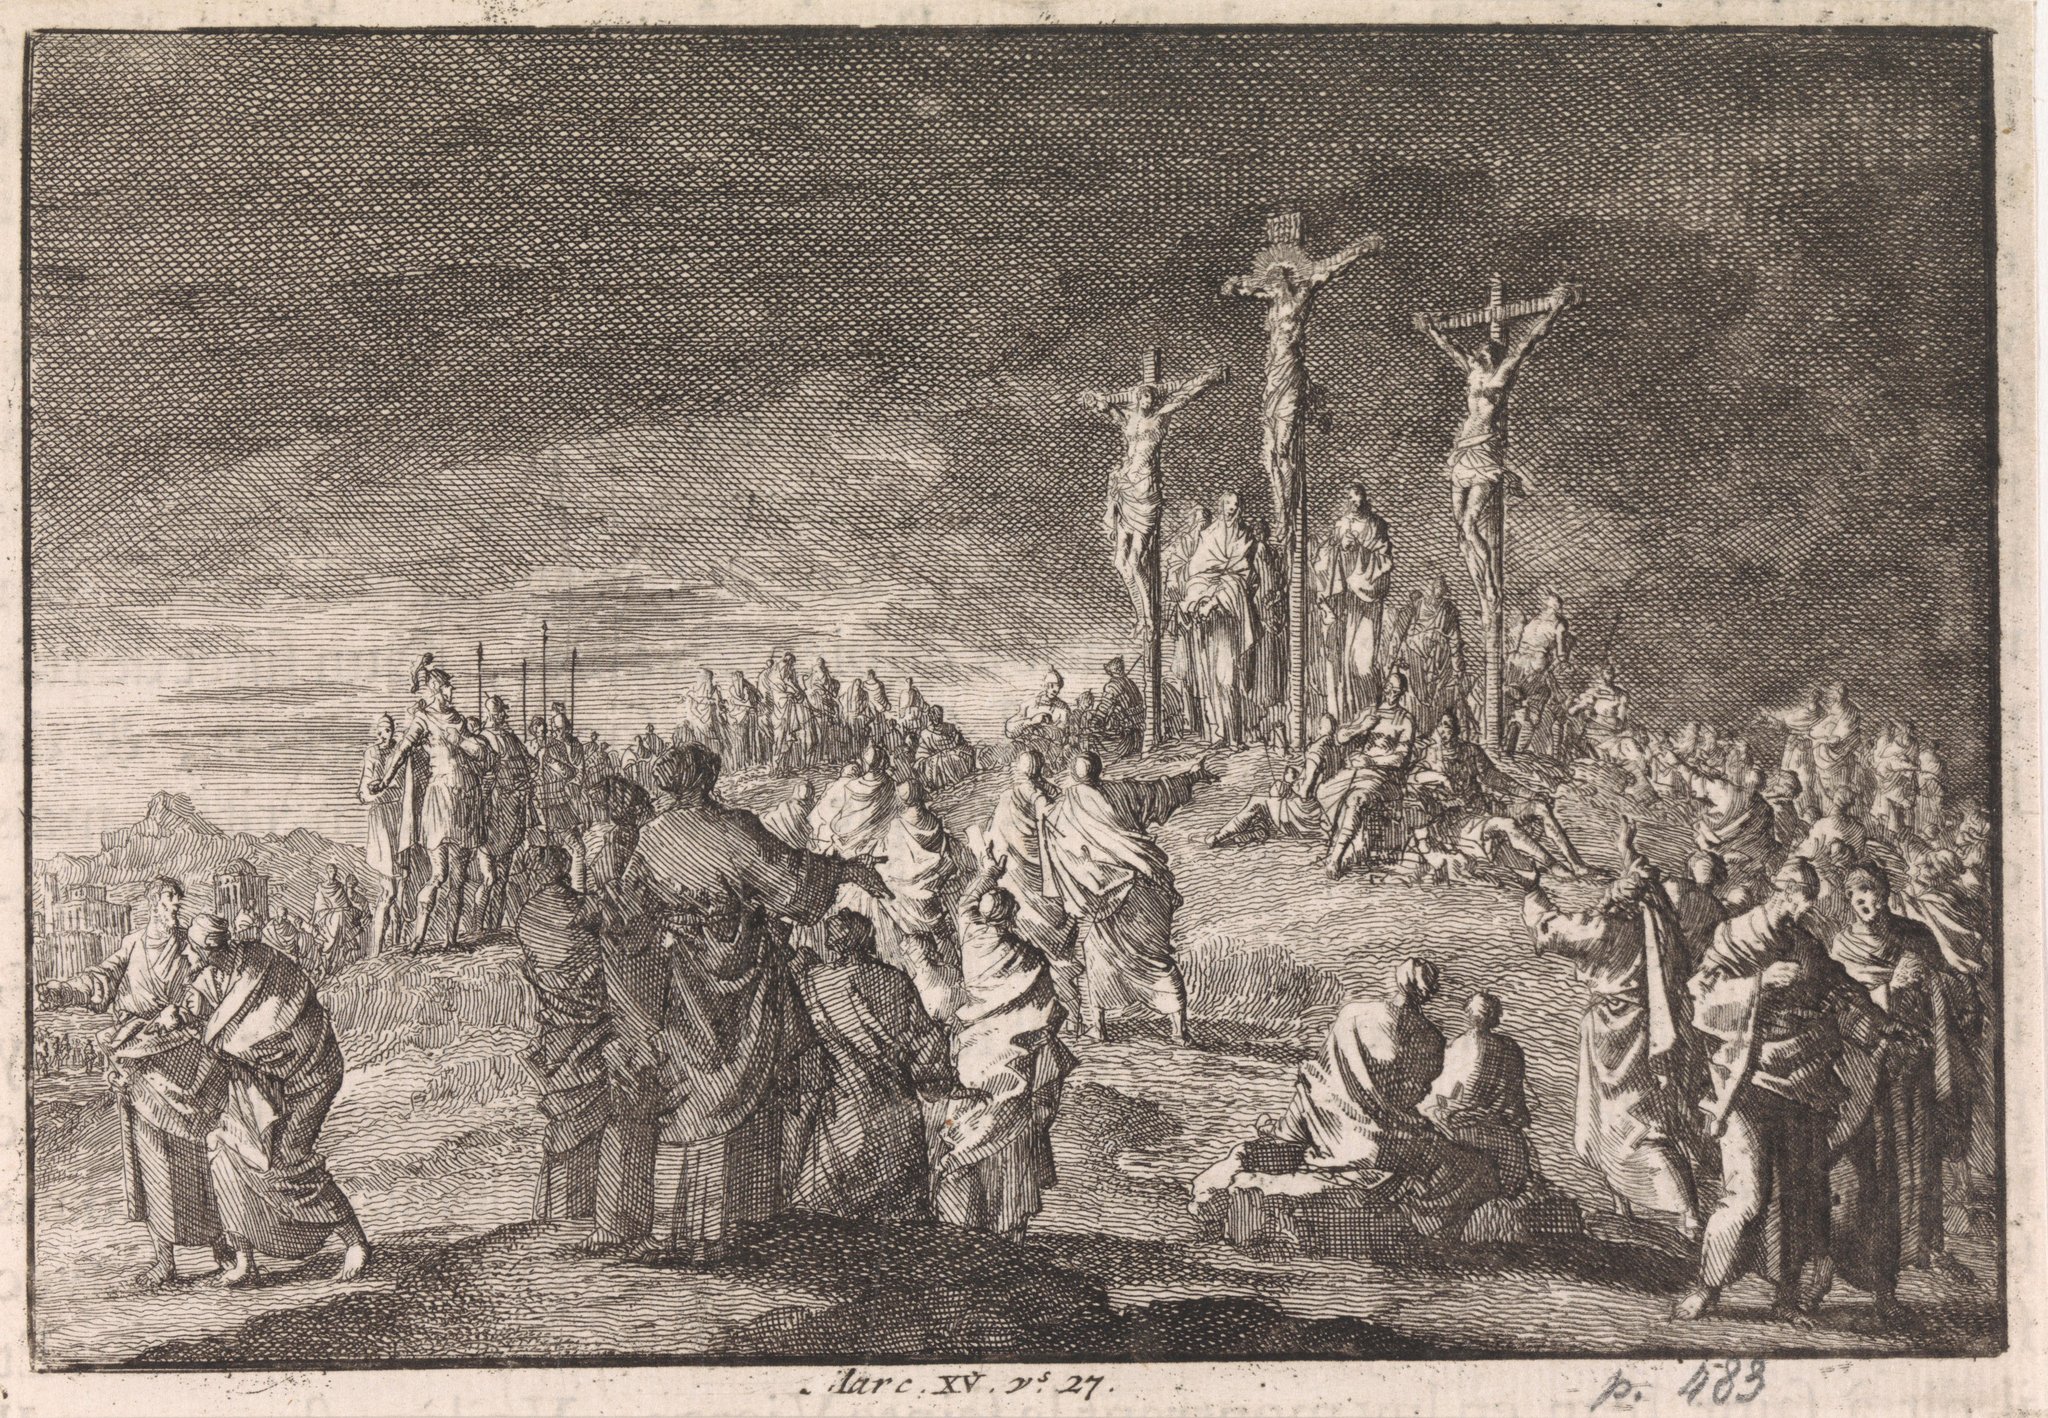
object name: print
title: Christus aan het kruis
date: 1703-1762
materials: paper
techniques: etching, letterpress printing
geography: amsterdam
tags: the crucifixion of christ: christ's death on the cross; golgotha (matthew 27:45-58; mark 15:33-45; luke 23:44-52; john 19:25-38)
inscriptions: collector's mark: Lugt 2228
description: De prent komt een eerste keer voor als boekillustratie voor David Martin. Historie des Ouden en Nieuwen Testaments. Amsterdam, Pieter Mortier, 1703. Deel II. De boekillustraties voor de Mortierbijbel hebben verschillende staten en kopieën, waarbij de chronologische volgorde moeilijk te achterhalen valt. Als boekillustraties werden ze bovendien herhaaldelijk opnieuw gebruikt voor andere boekwerken.